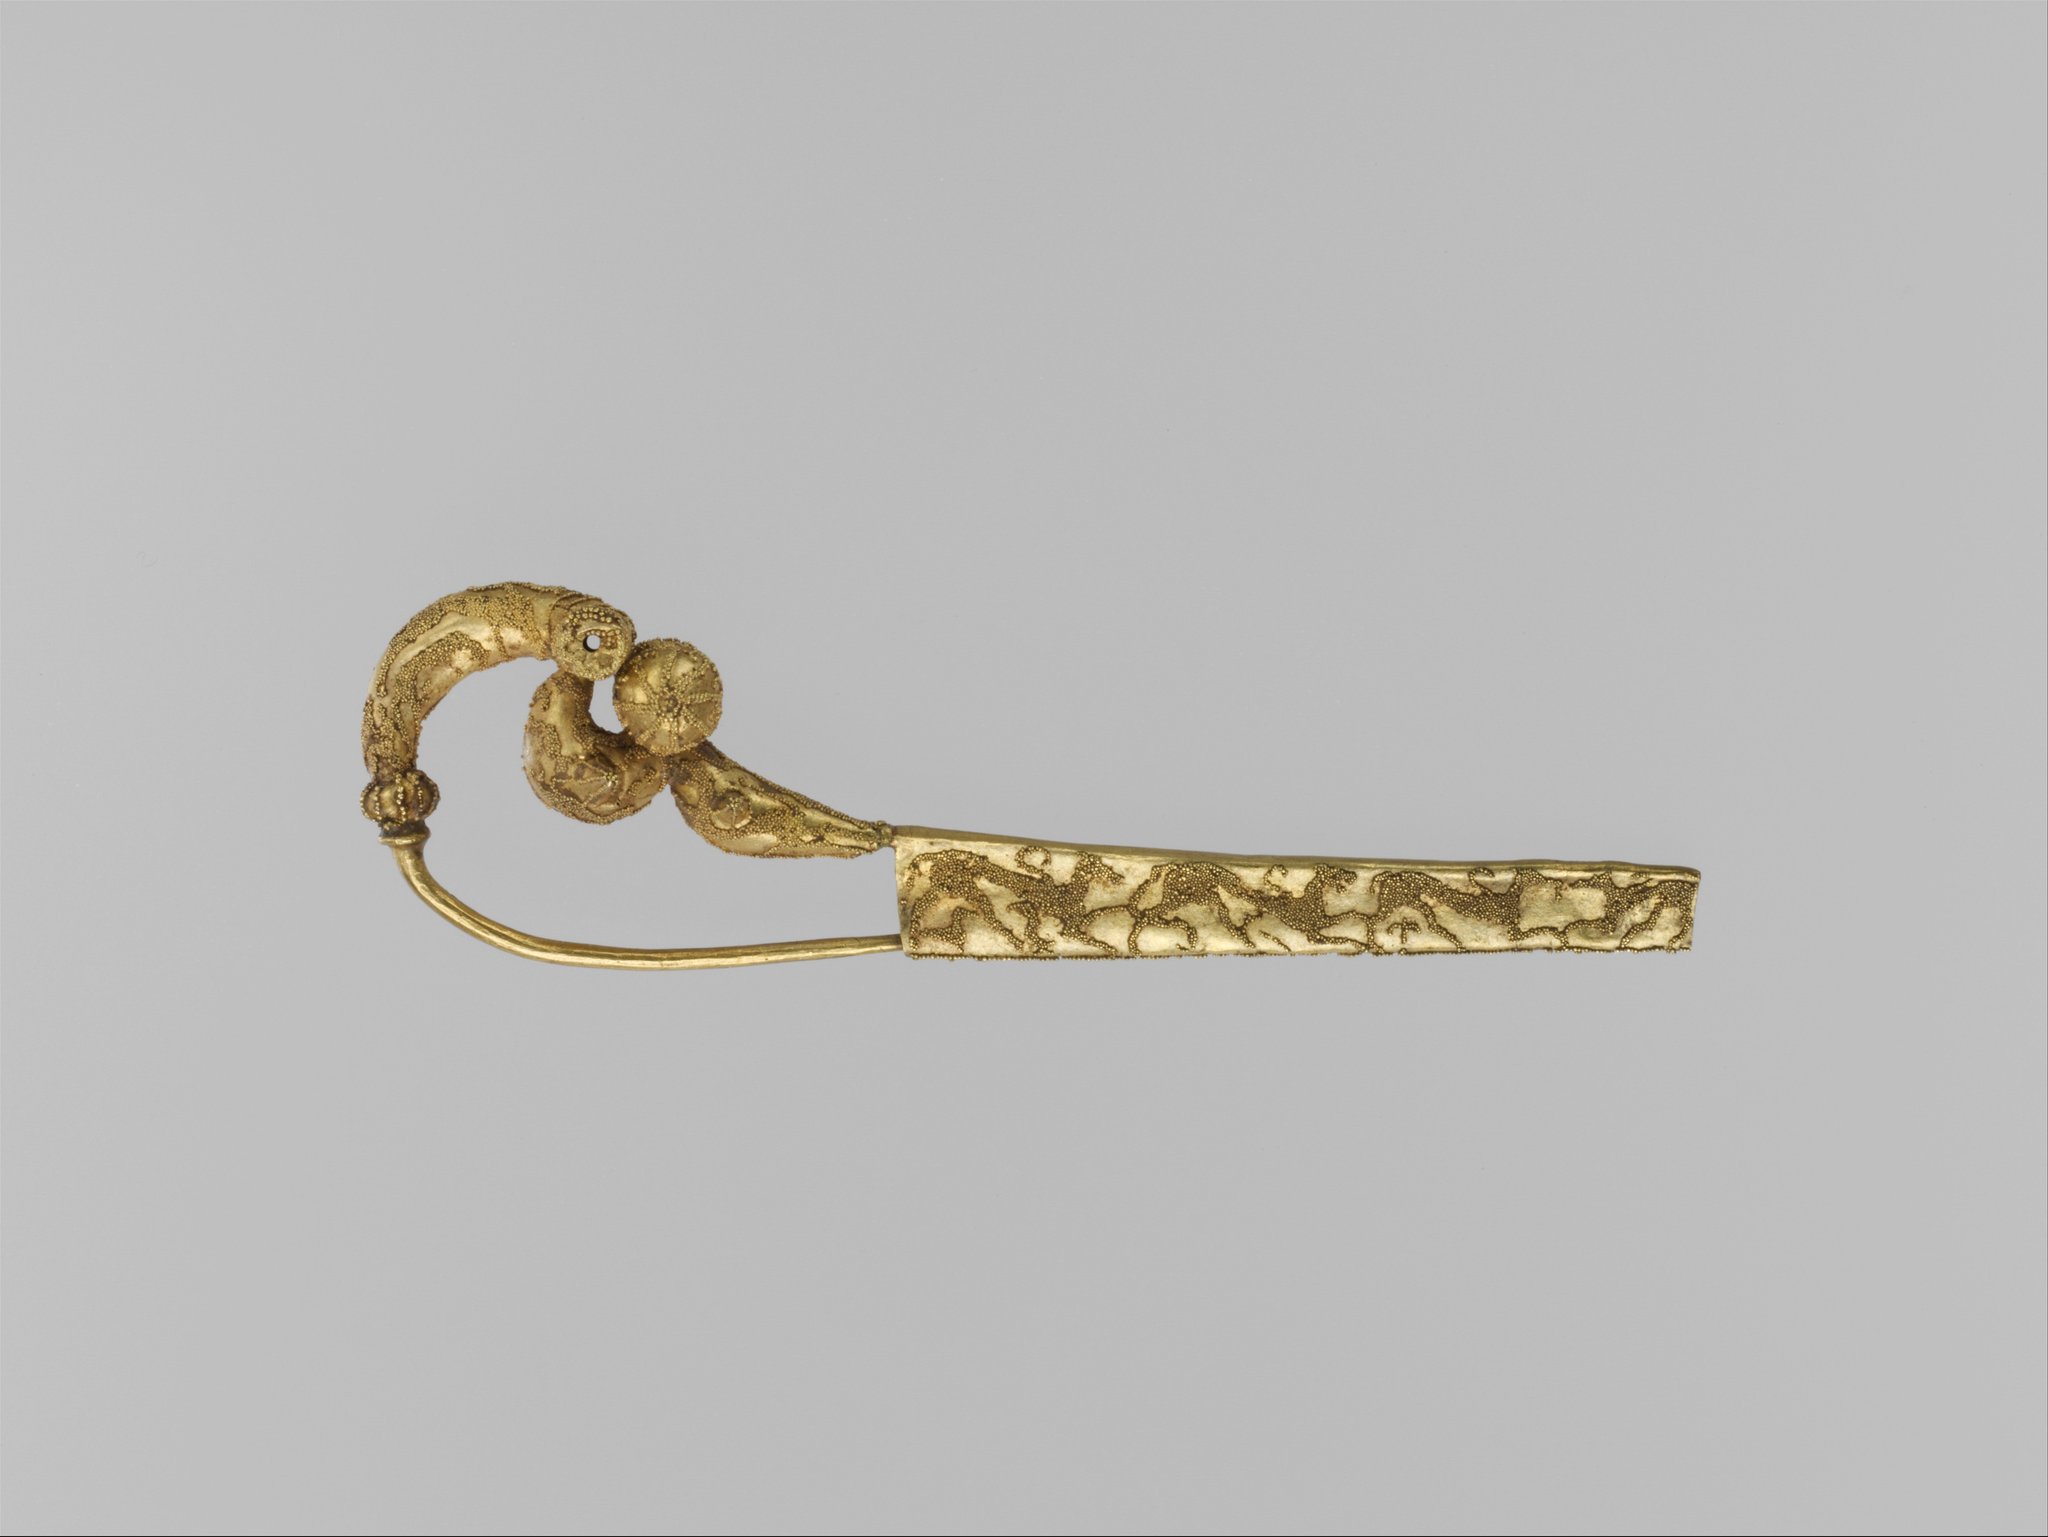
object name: fibula, serpentine type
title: Gold serpentine fibula (safety pin) with animals in granulation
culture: etruscan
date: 700-601 BCE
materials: gold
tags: animals